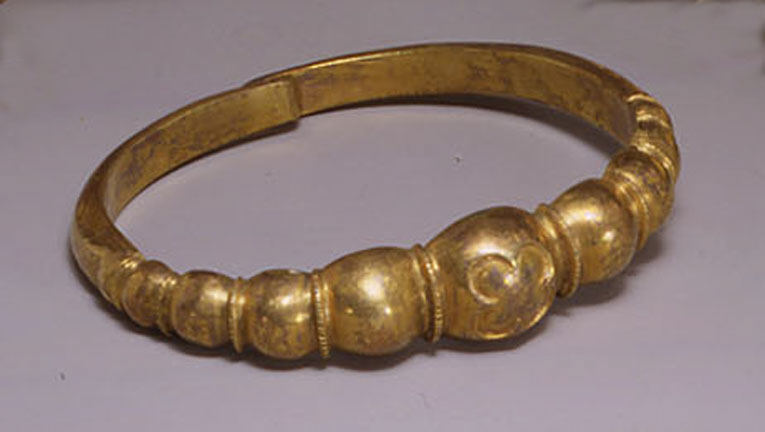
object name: bracelet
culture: indonesian, javanese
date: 701-933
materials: gold